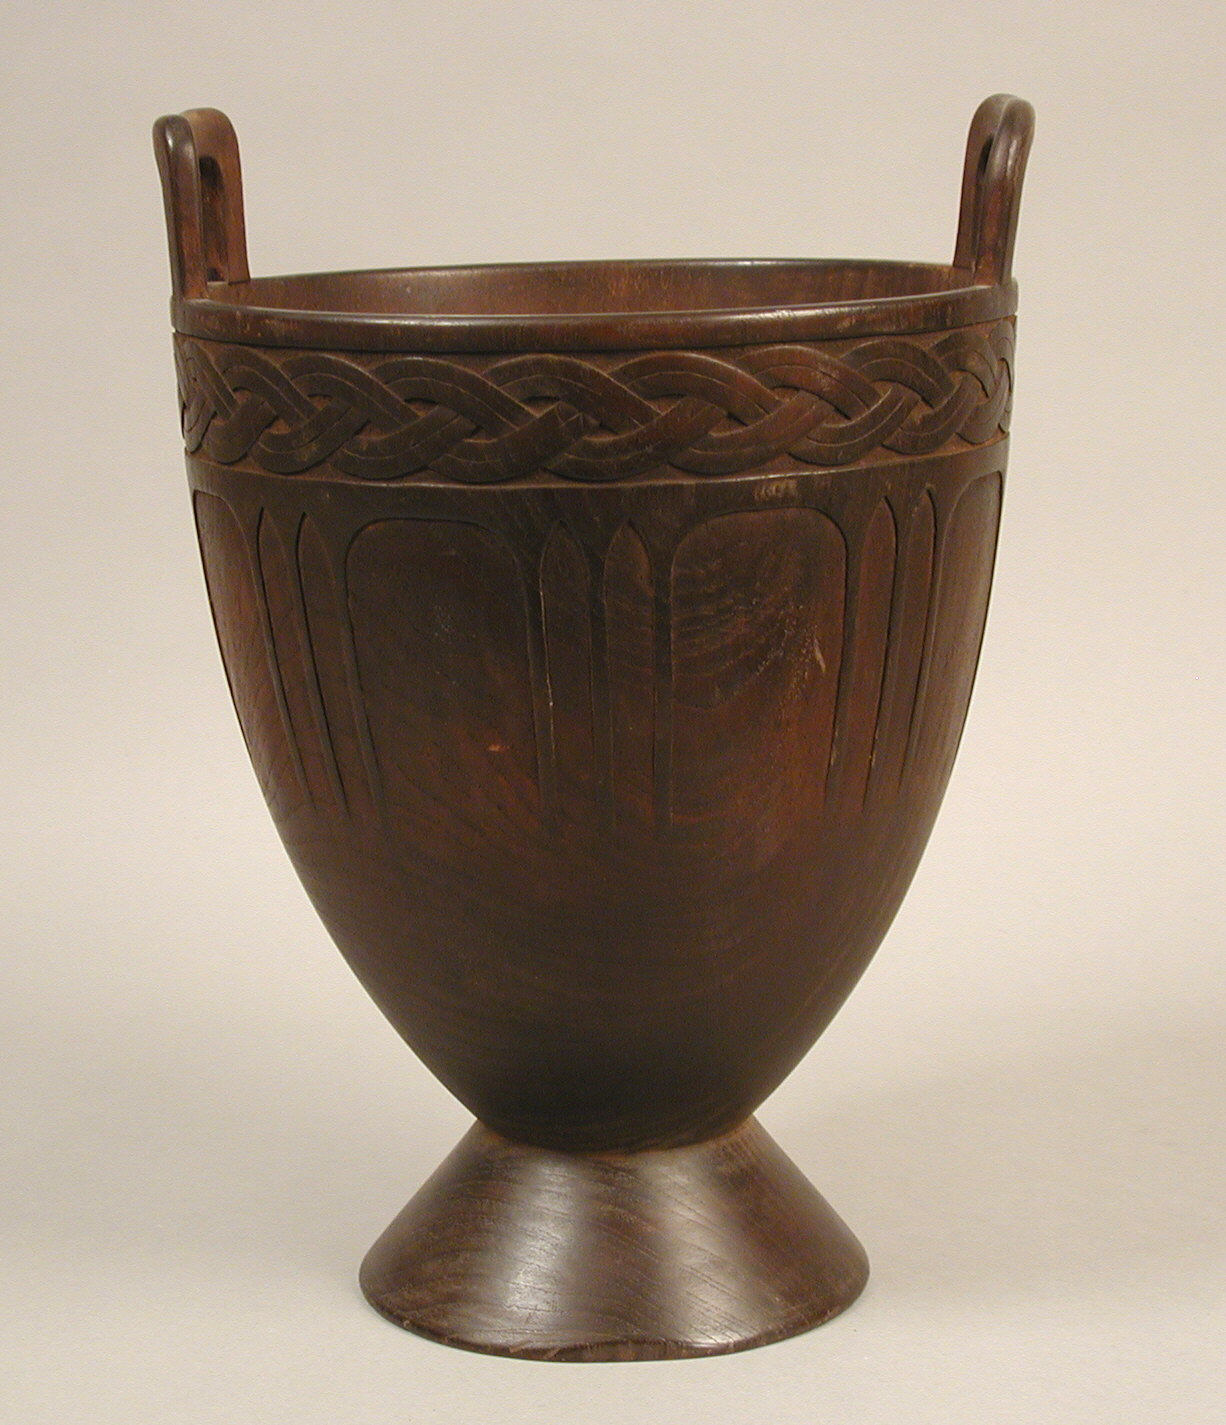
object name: situla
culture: irish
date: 1901-1933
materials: wood